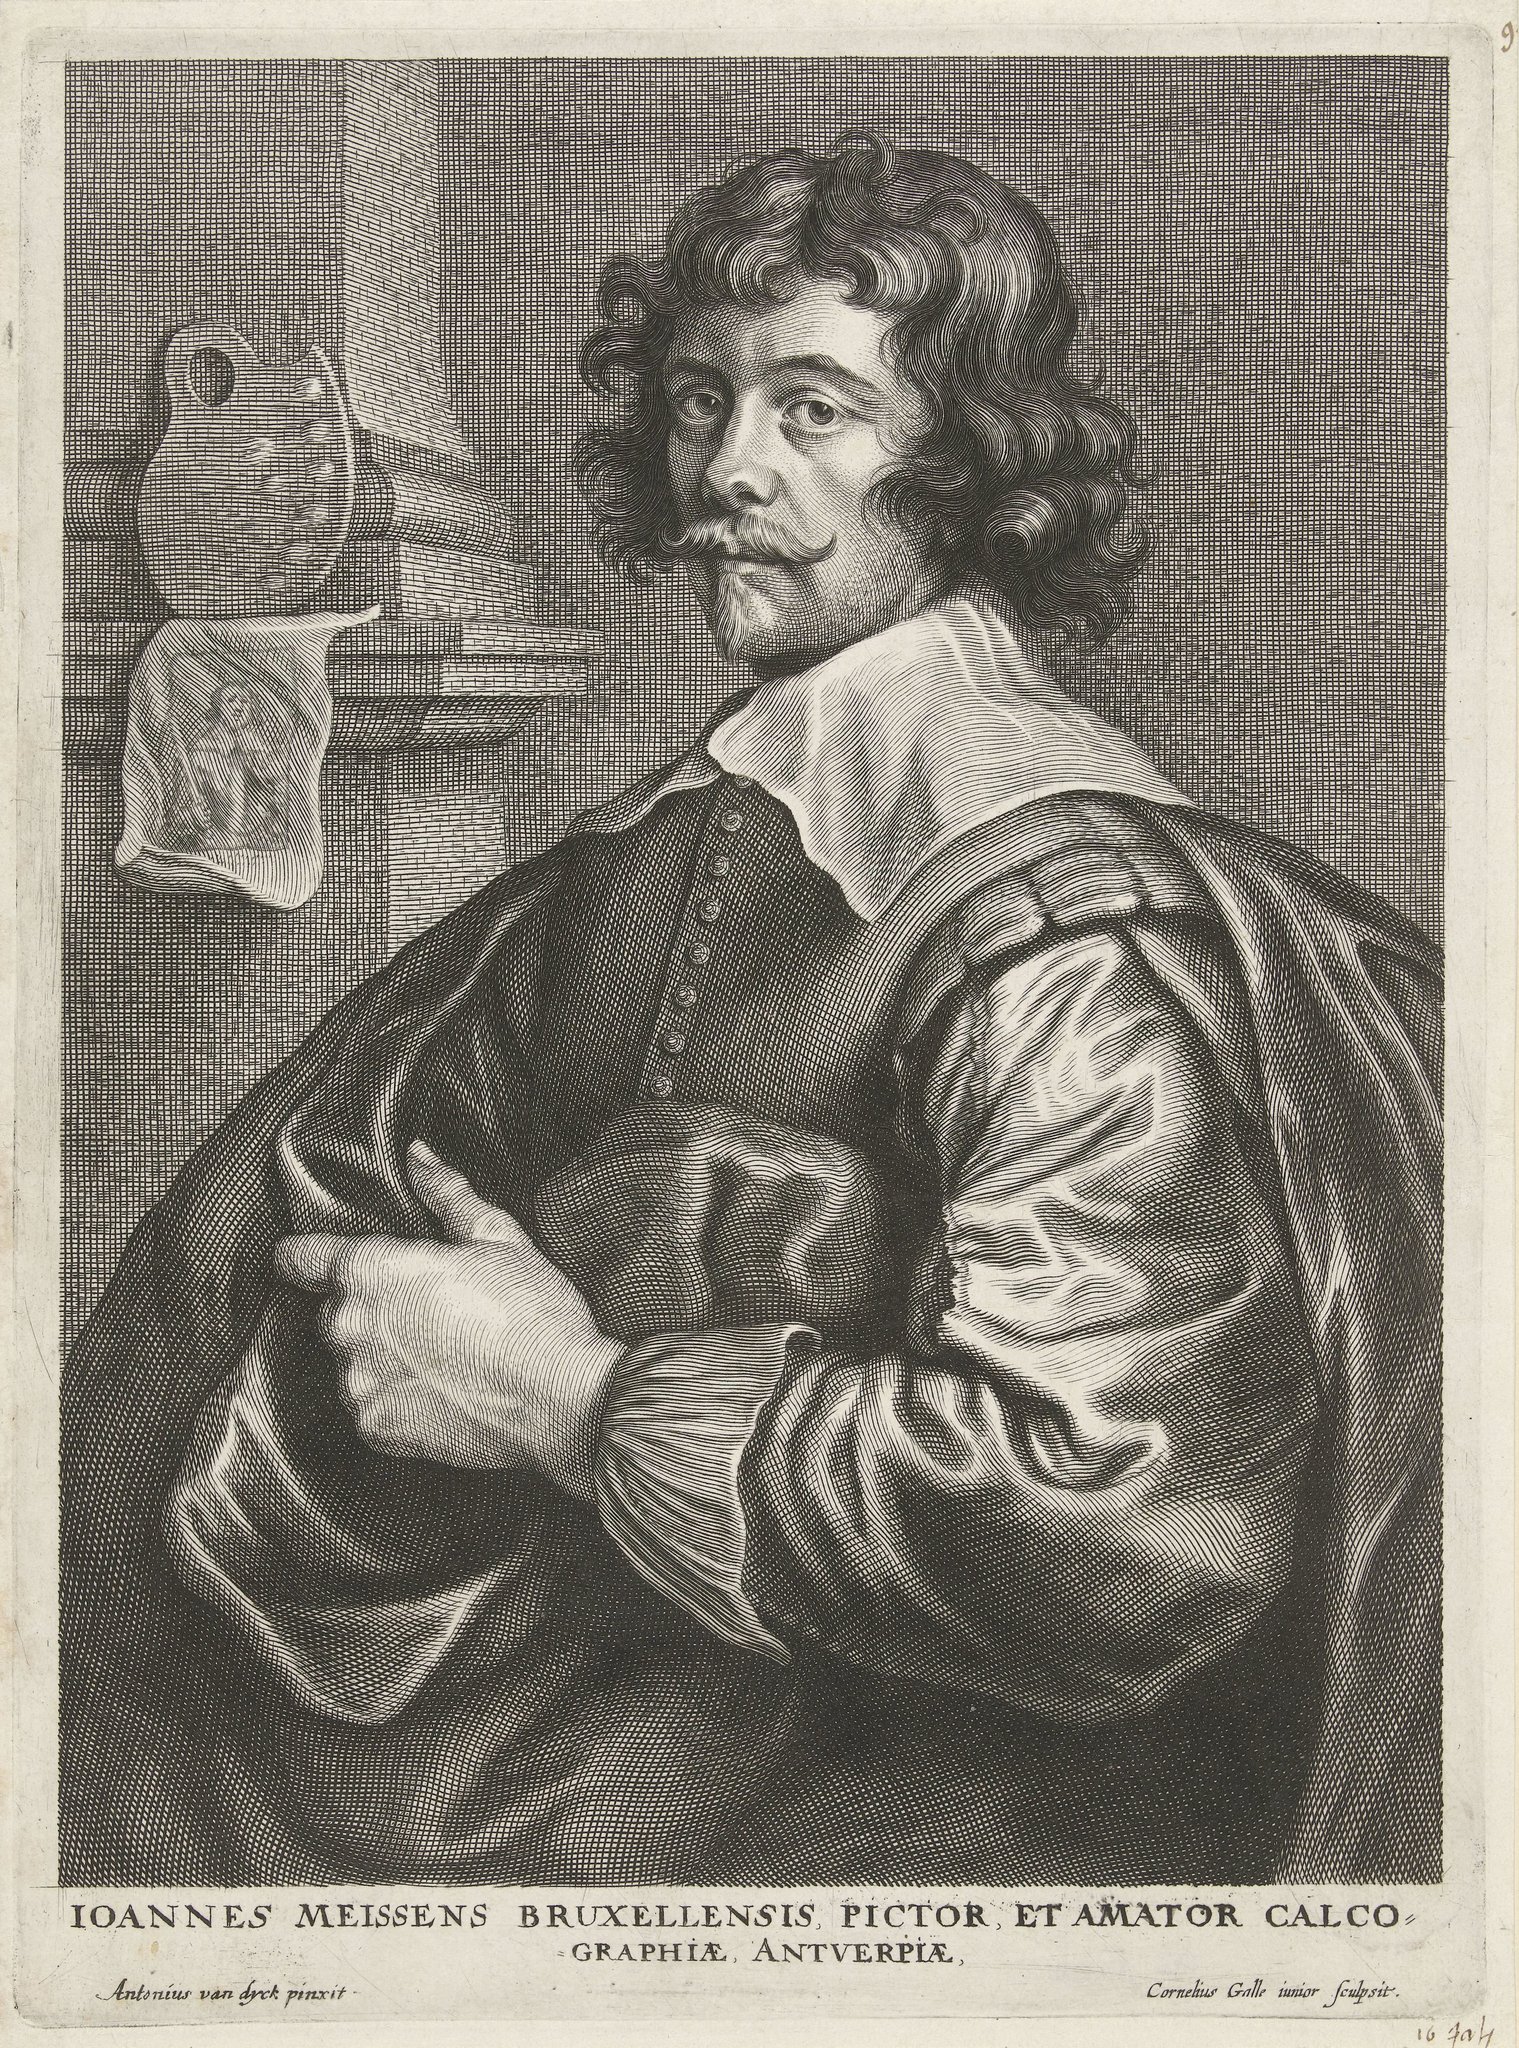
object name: print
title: Portret van Joannes Meyssens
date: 1638-1650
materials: paper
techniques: engraving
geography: antwerp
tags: brussels, antwerp, print maker, publisher, joannes meyssens, portrait, self-portrait of artist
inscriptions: collector's mark: Lugt 240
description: Portret van de kunstenaar en uitgever Joannes Meyssens. Op de achtergrond een basement met erop een portretprent en een palet.